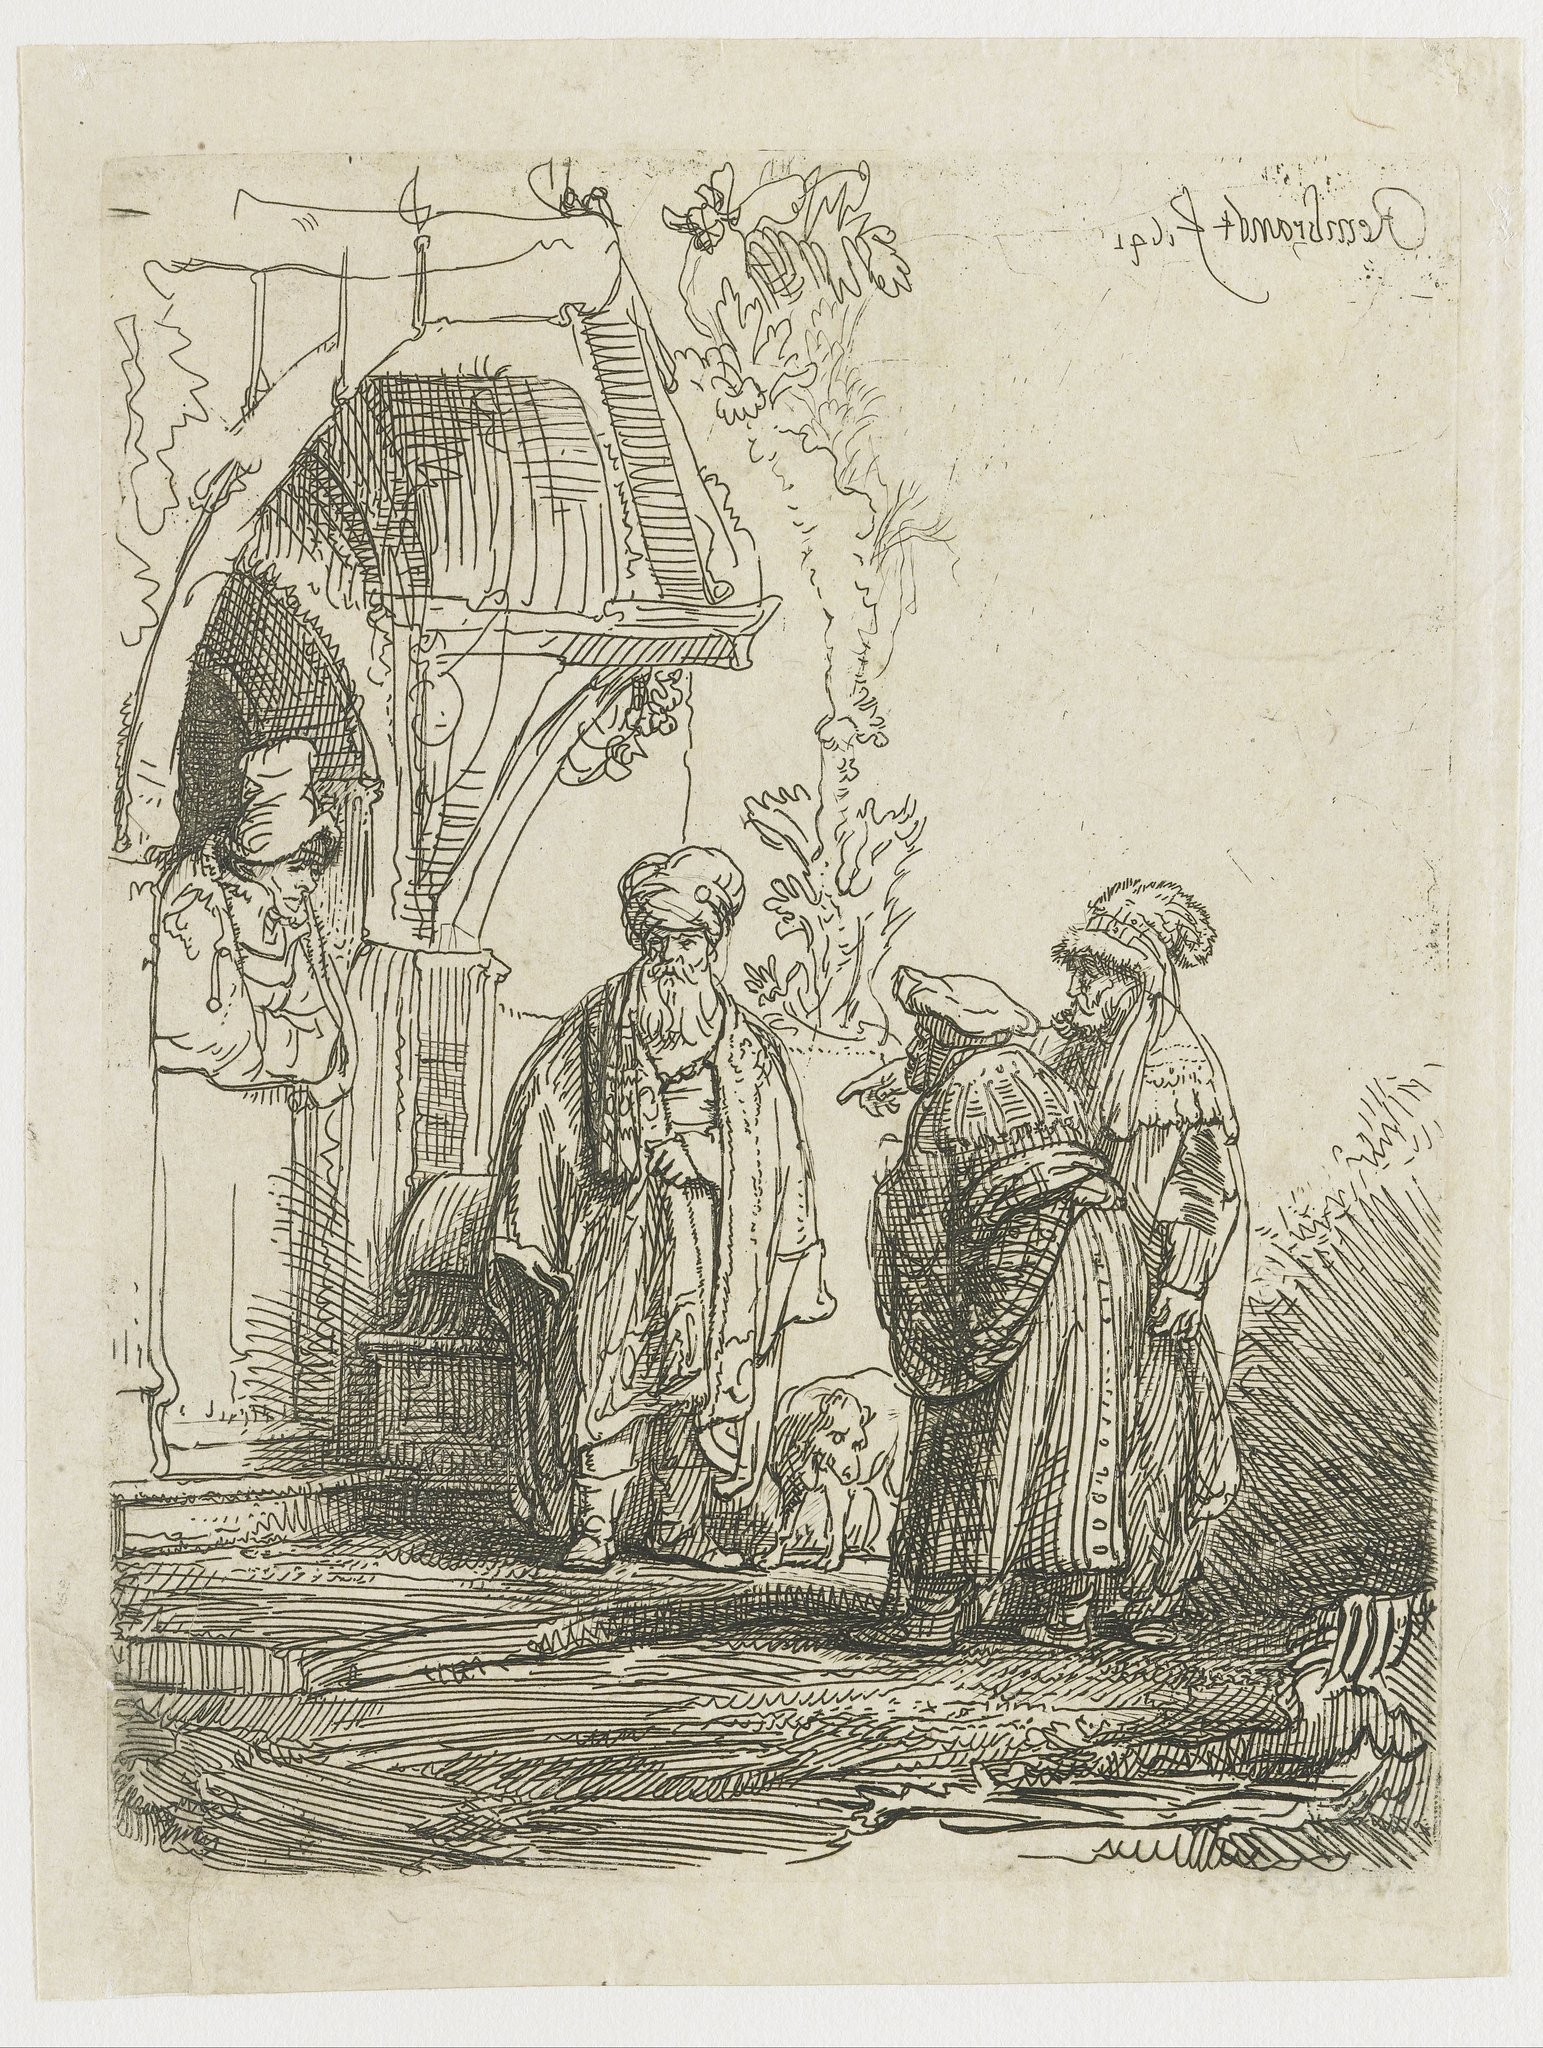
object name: print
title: Three oriental figures (Jacob and Laban?)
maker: rembrandt van rijn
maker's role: draughtsman, painter, print maker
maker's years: 1606-1669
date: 1641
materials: paper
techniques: drypoint, etching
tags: the partnership with laban ~ story of jacob (genesis 30:25-43)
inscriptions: collector's mark: Lugt 2165, signature and date: ‘Rembrandt f 1641 (spiegelbeeldig)’